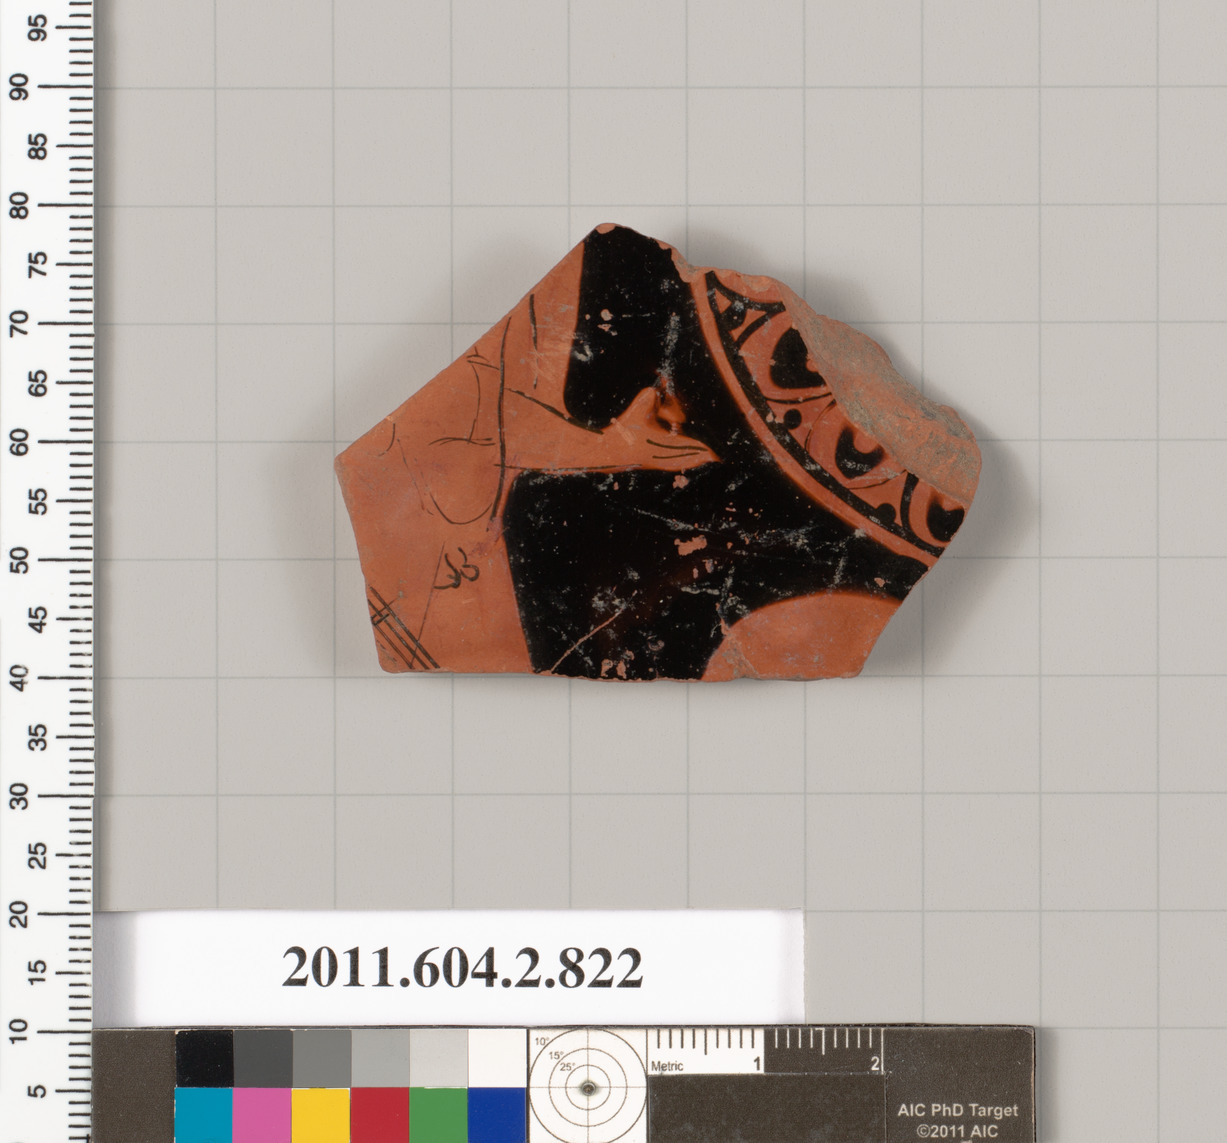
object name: bell krater fragment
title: Terracotta fragment of a bell-krater (bowl for mixing wine and water)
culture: greek, attic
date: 450-426 BCE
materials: terracotta